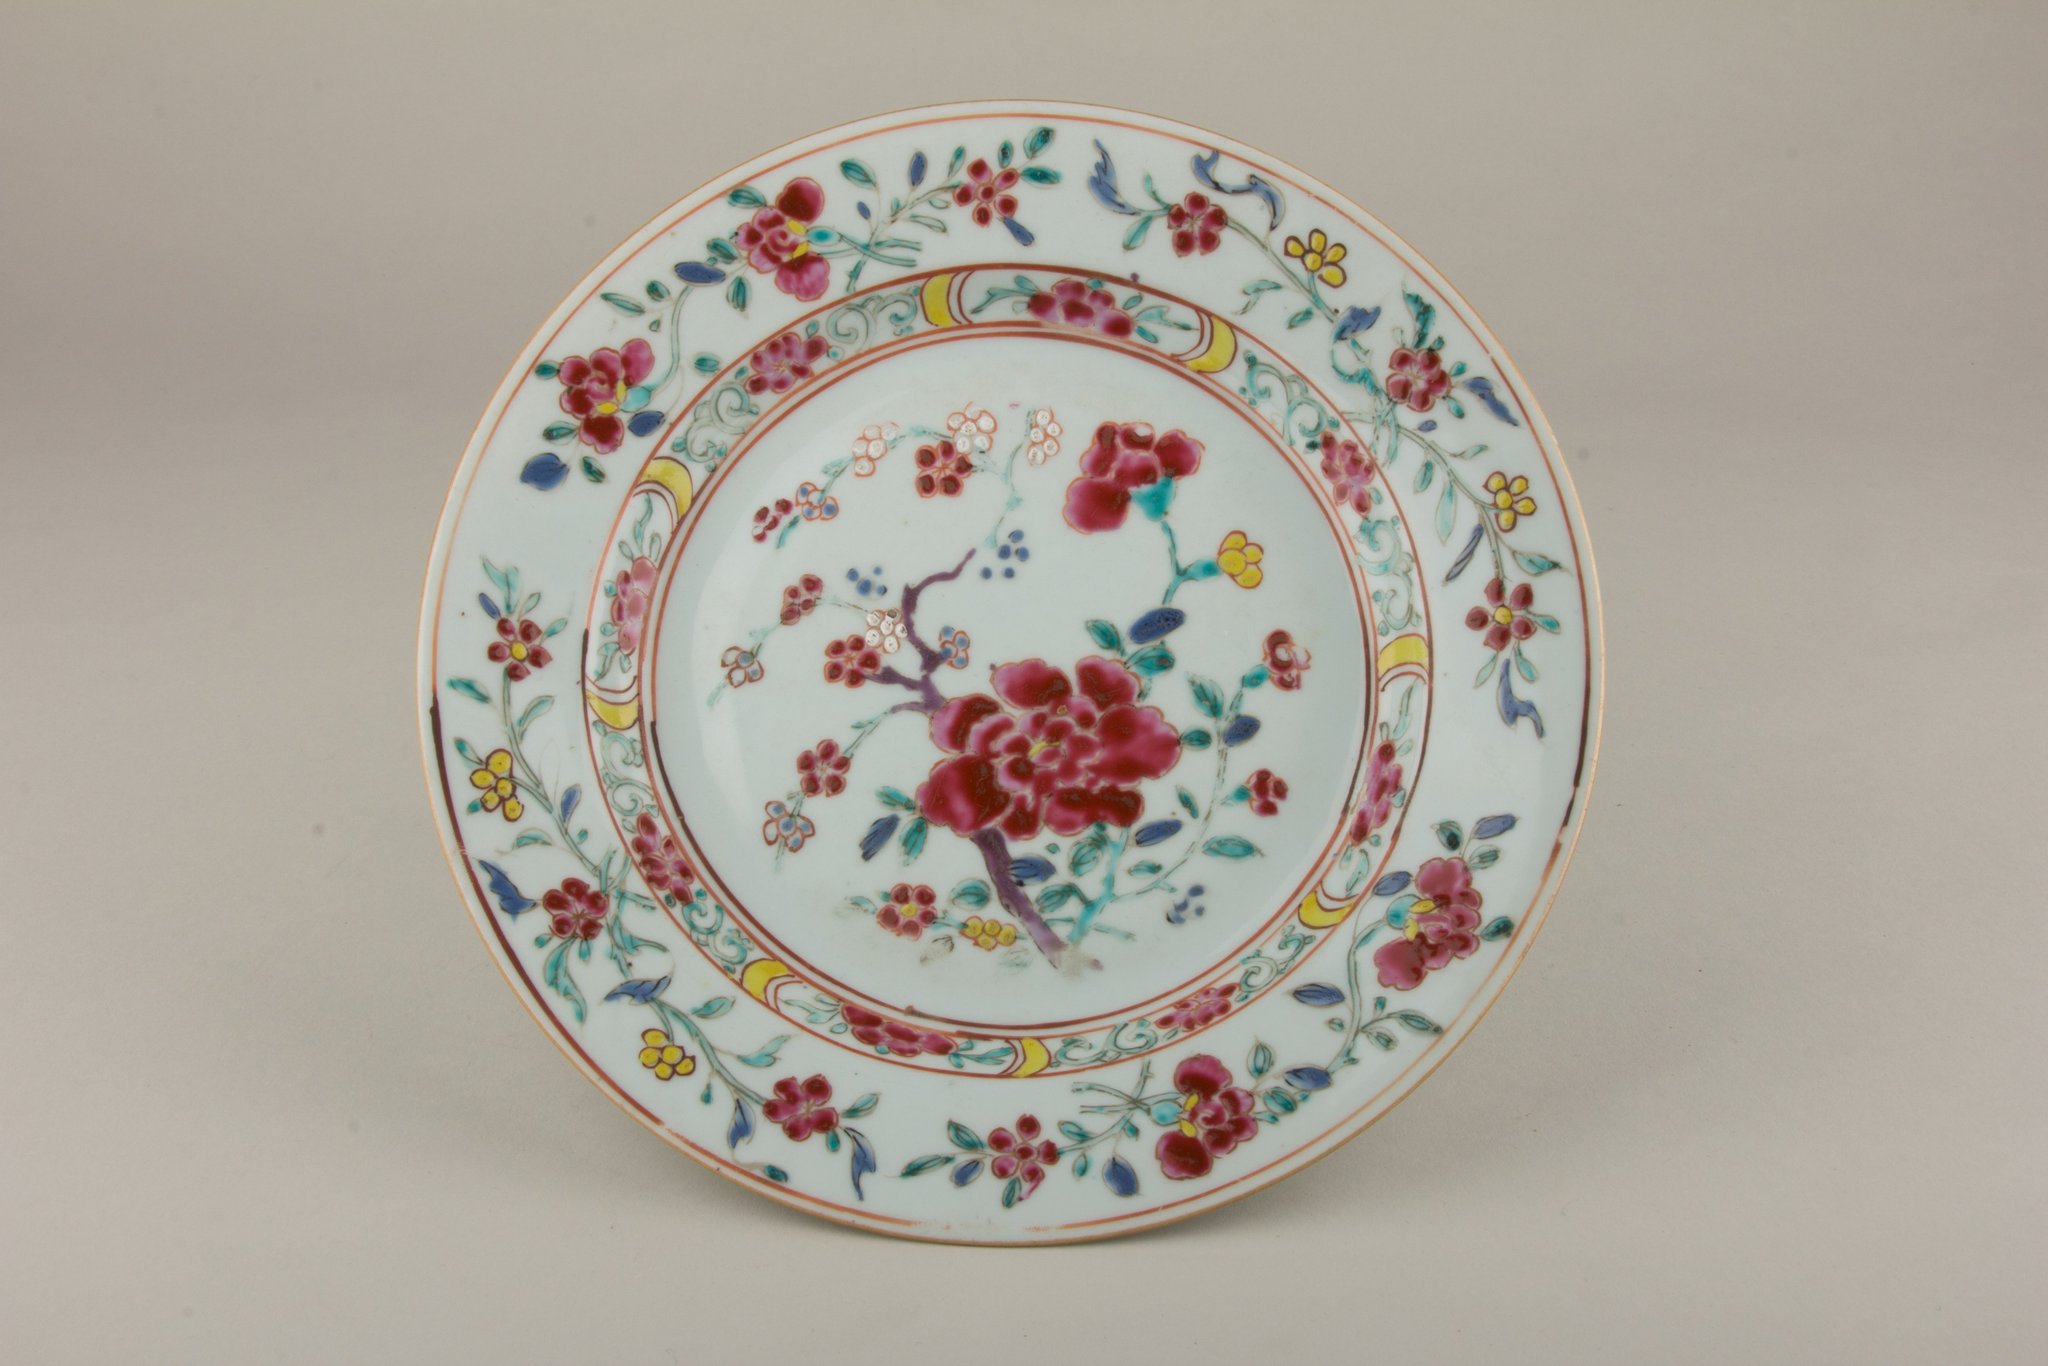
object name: plate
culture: chinese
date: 1767-1900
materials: enamel, porcelain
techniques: overglaze, painting, polychrome